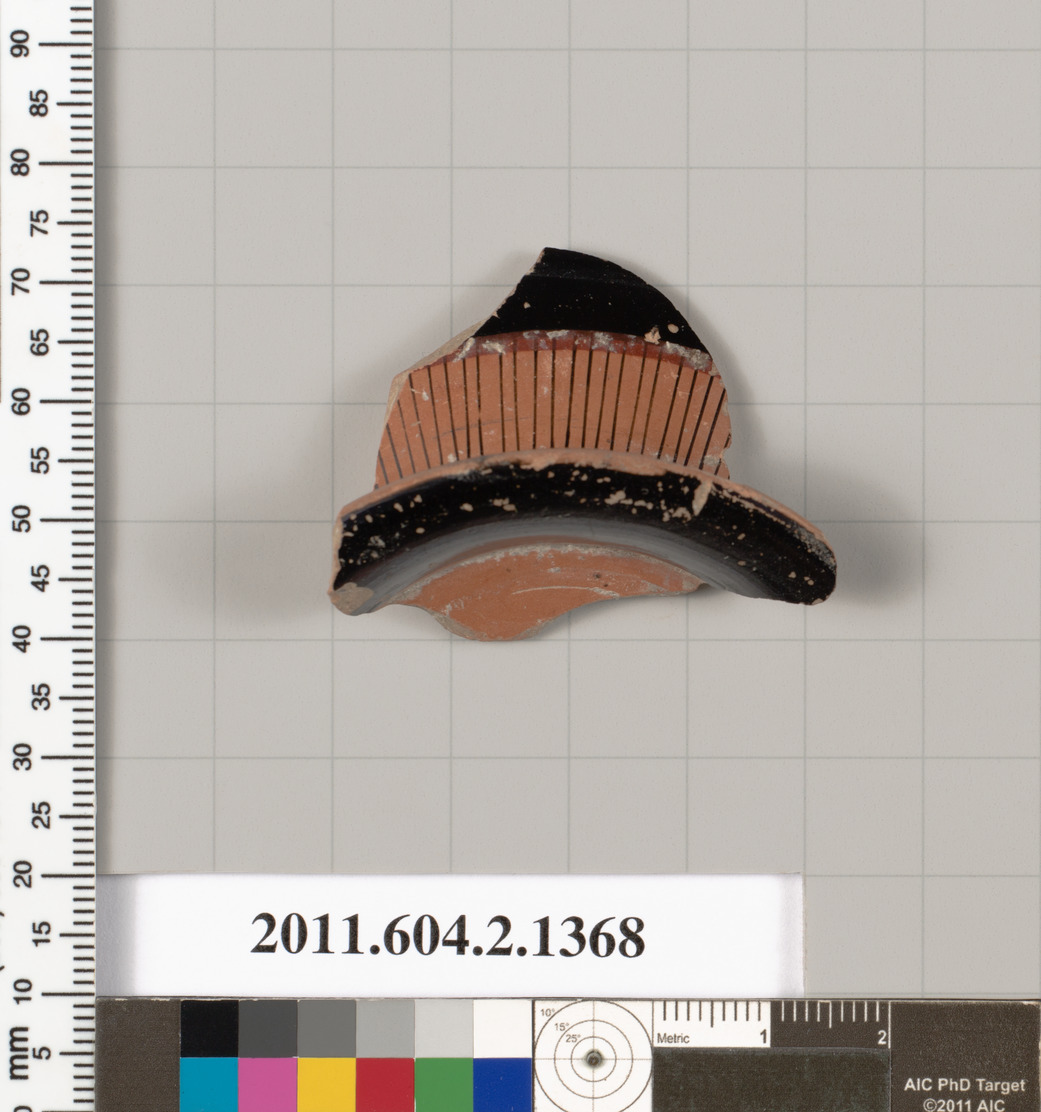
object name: skyphos fragment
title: Terracotta fragment of a skyphos (deep drinking cup)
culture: greek, attic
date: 470-460 BCE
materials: terracotta